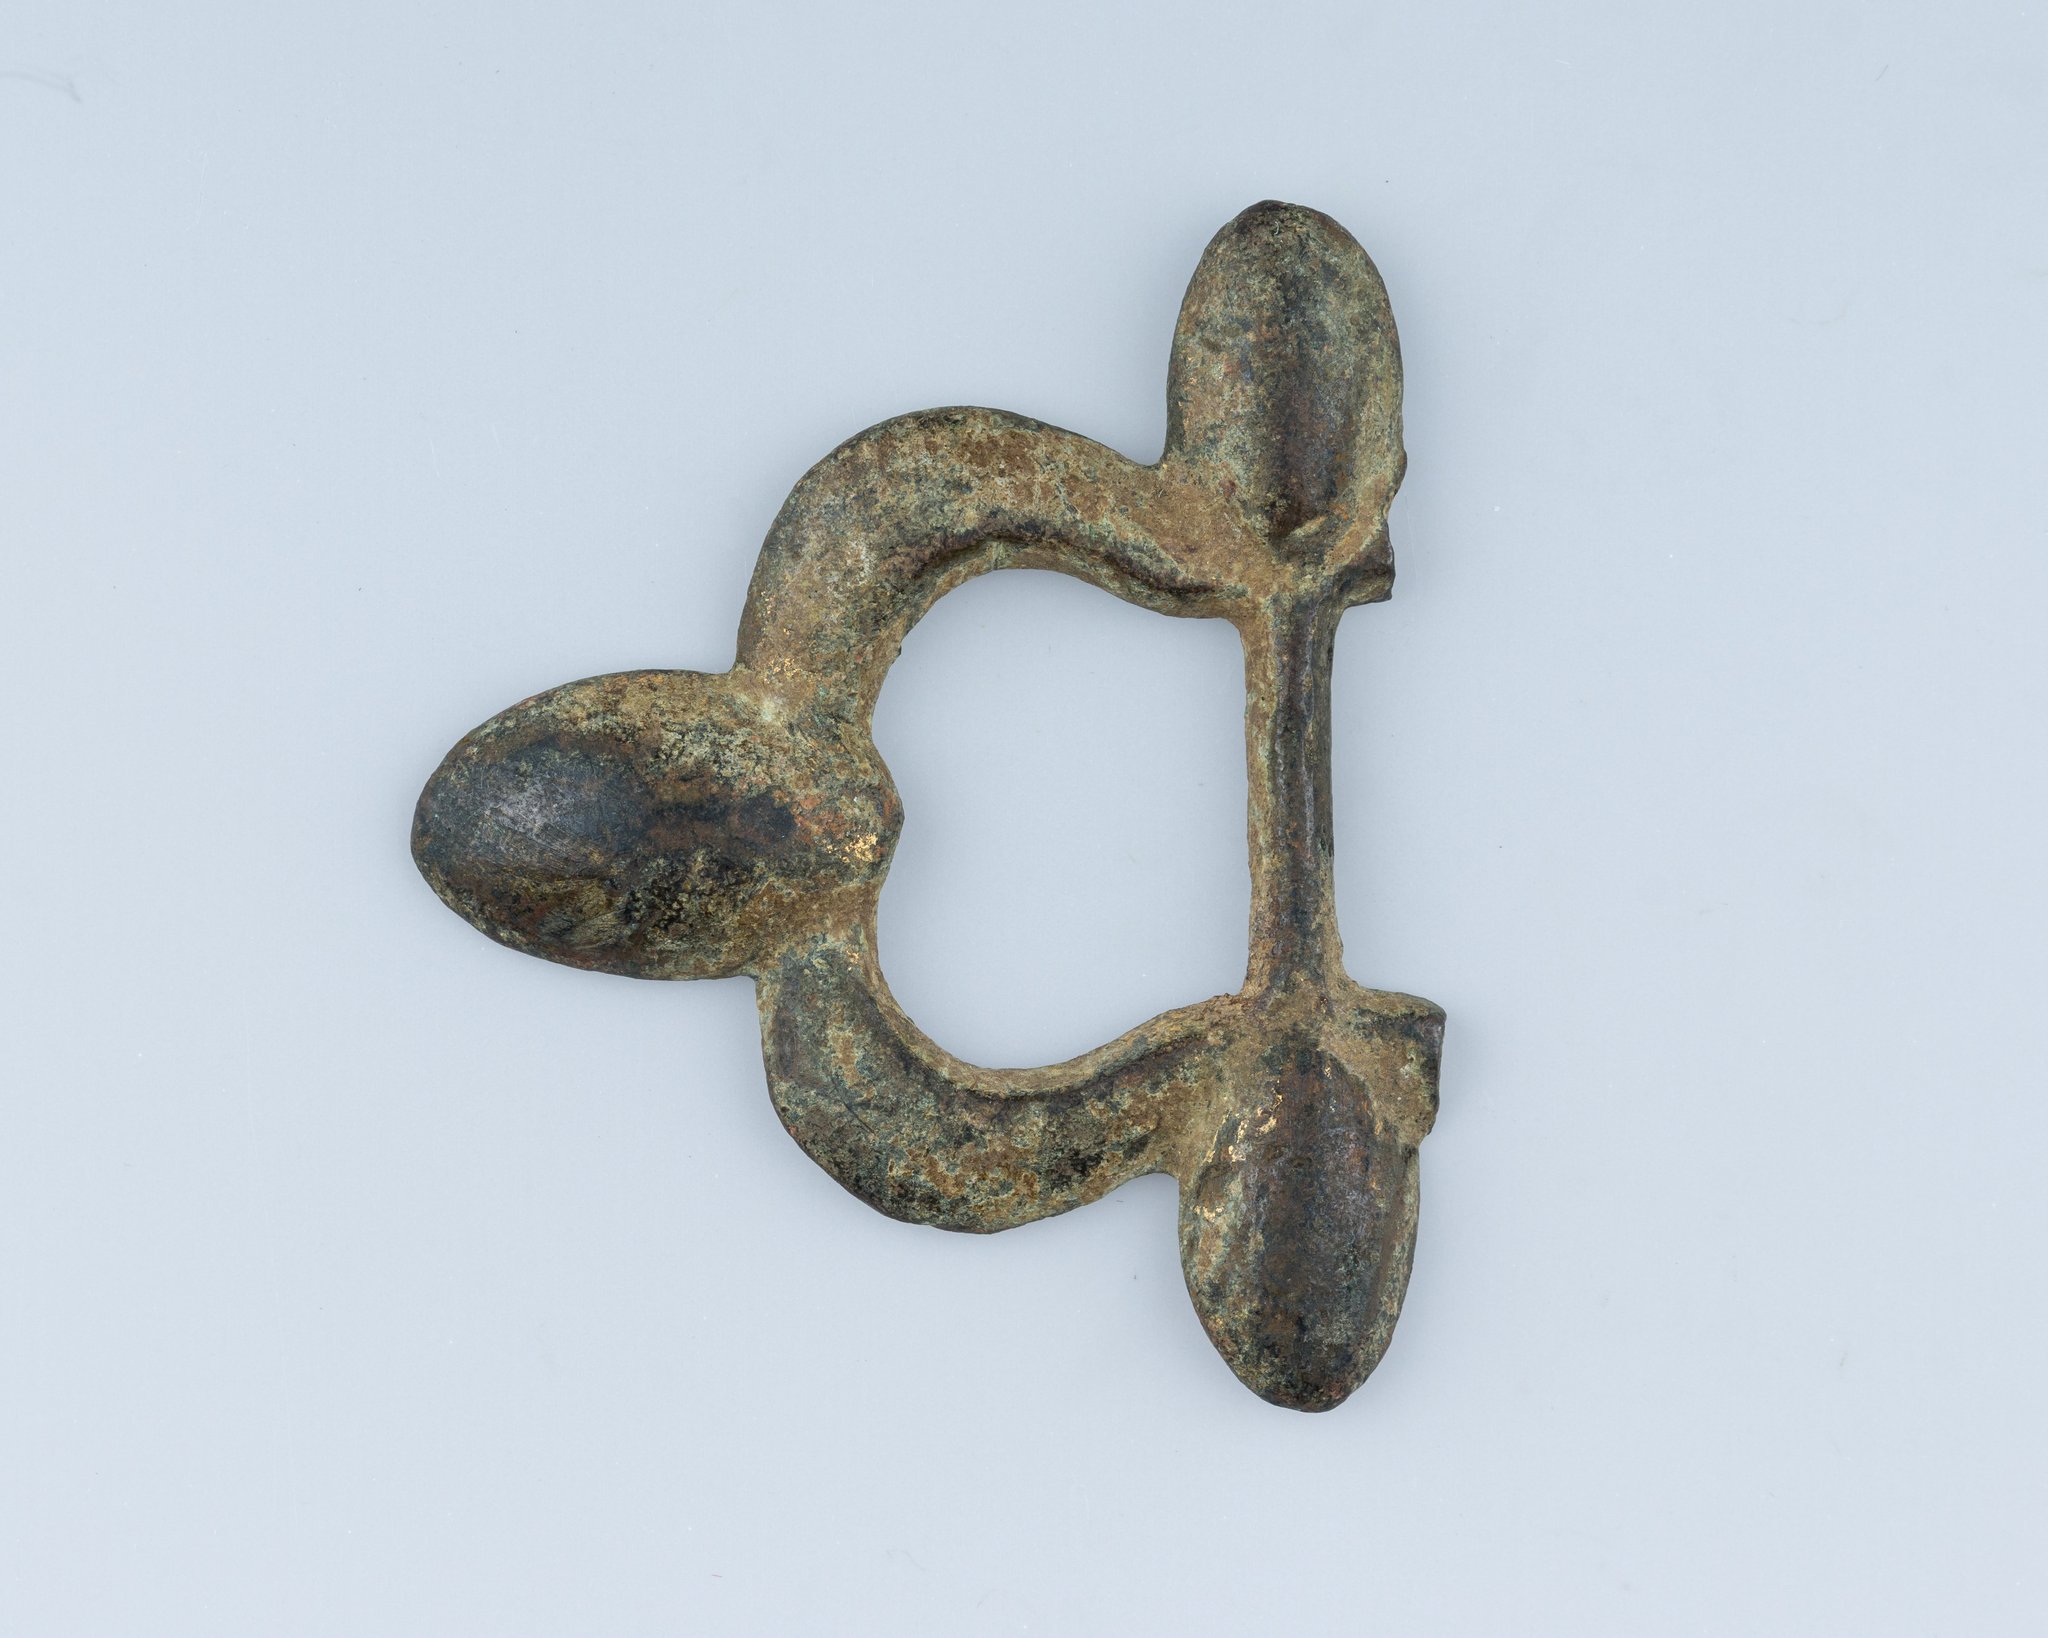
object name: buckle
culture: french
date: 1500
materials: bronze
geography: france